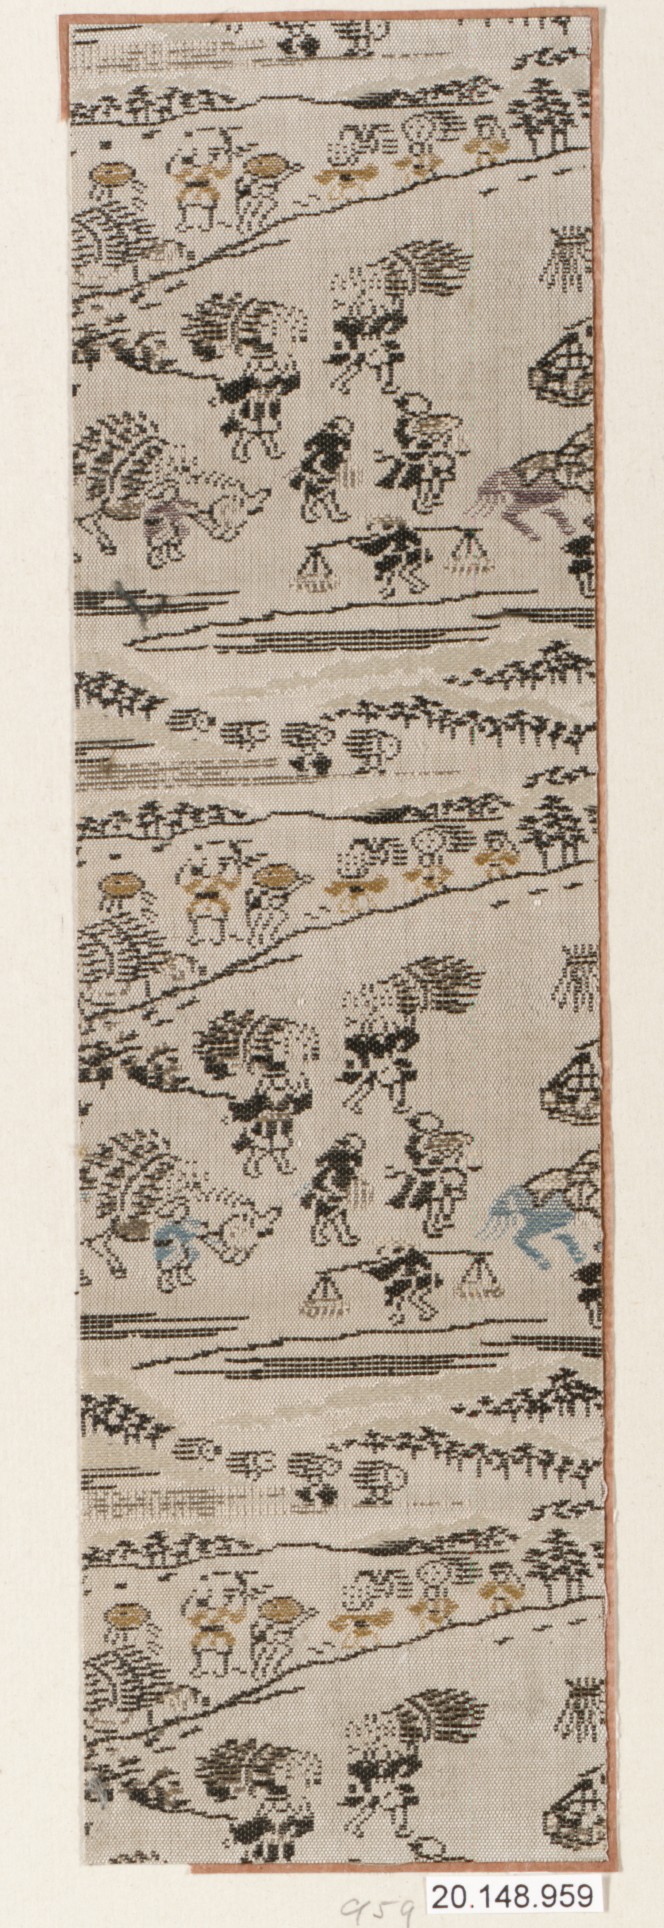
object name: piece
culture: japanese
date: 1801-1900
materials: silk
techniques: compound weave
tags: human figures